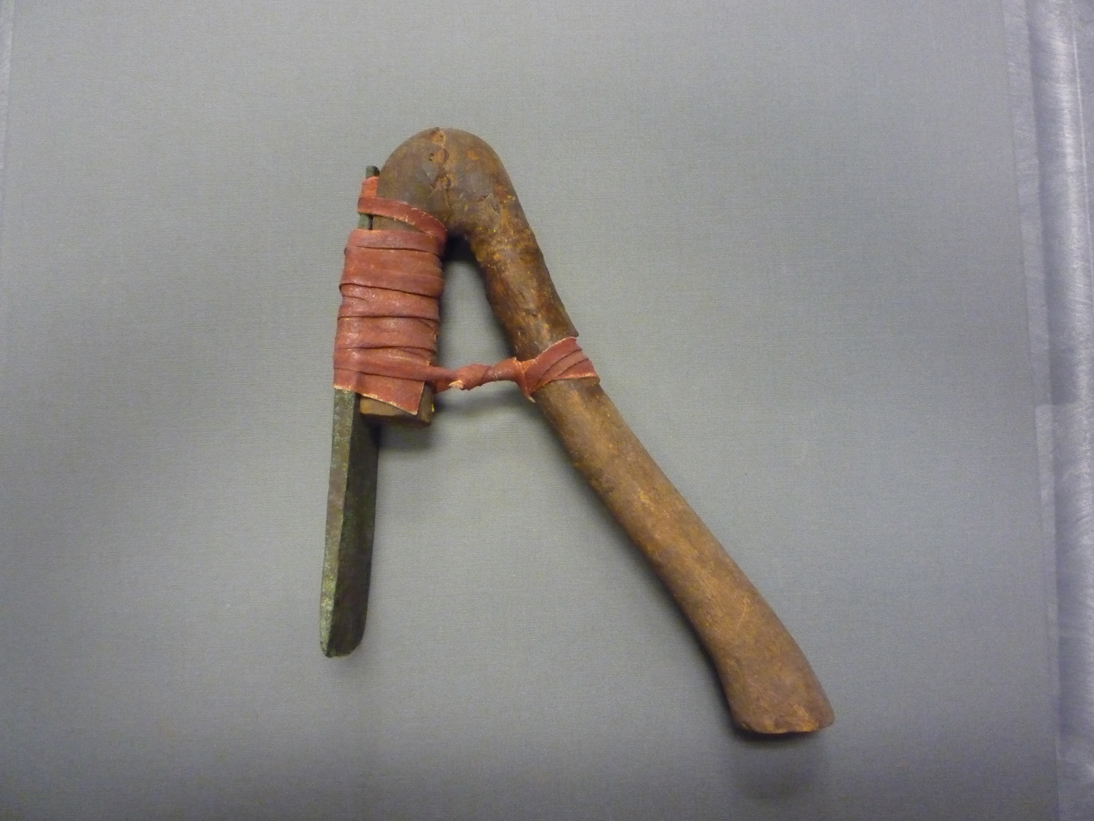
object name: adze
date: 1550-1295 BCE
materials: bronze, copper alloy, leather, wood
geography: egypt